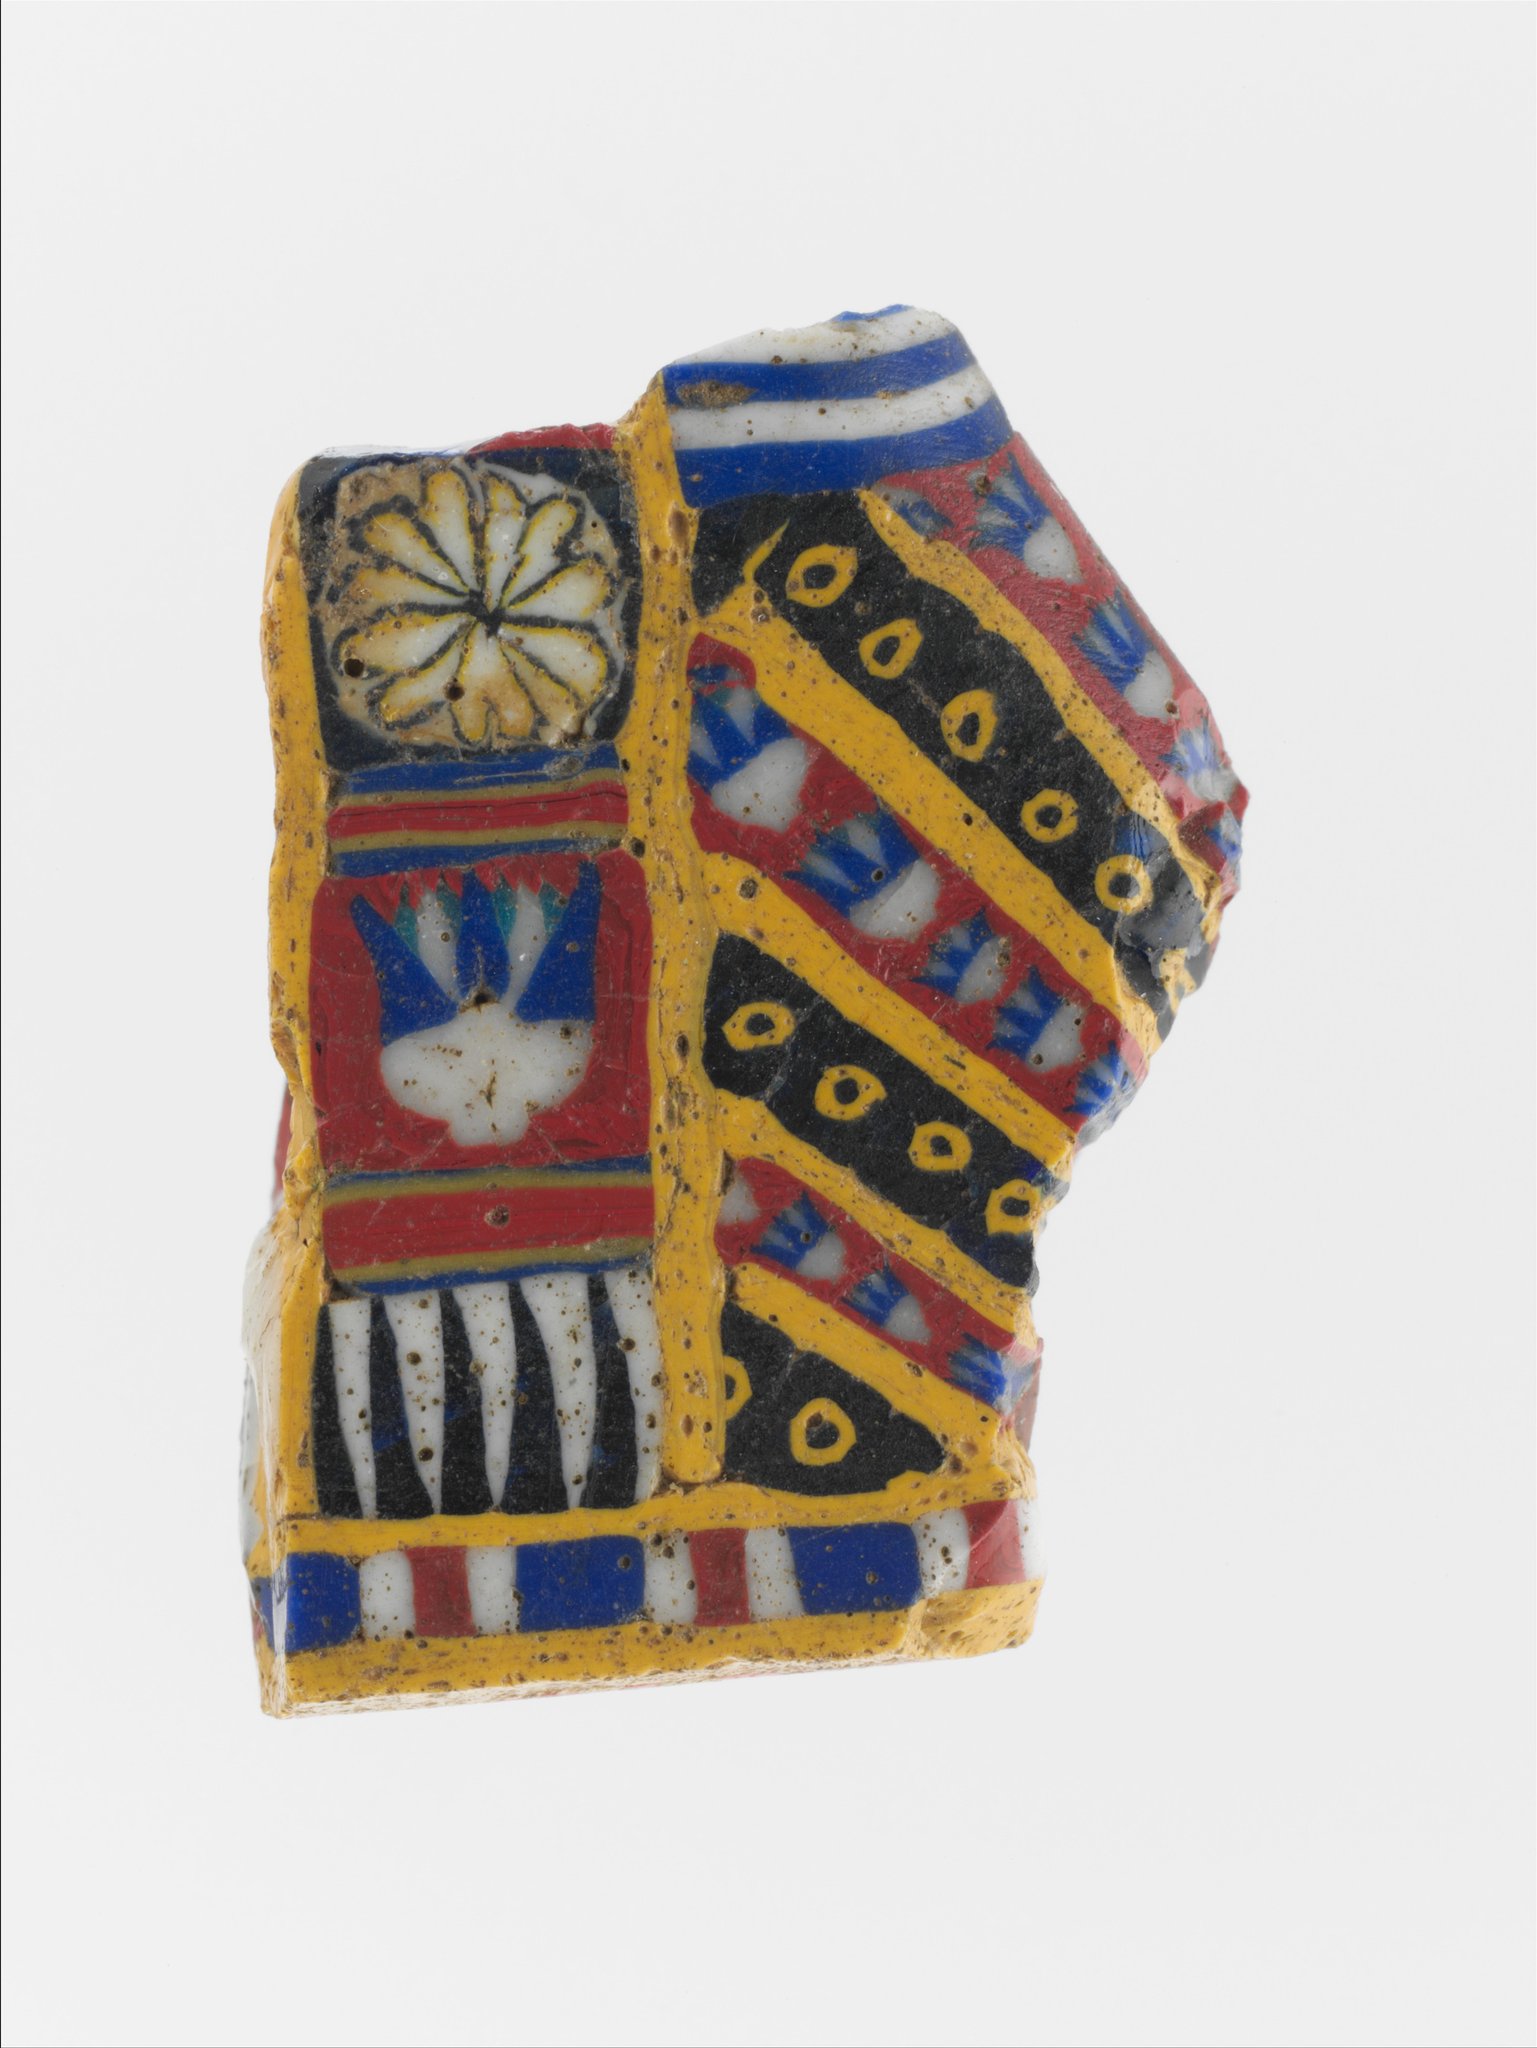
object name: mosaic block inlay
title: Glass mosaic relief fragment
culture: egyptian, ptolemaic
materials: glass